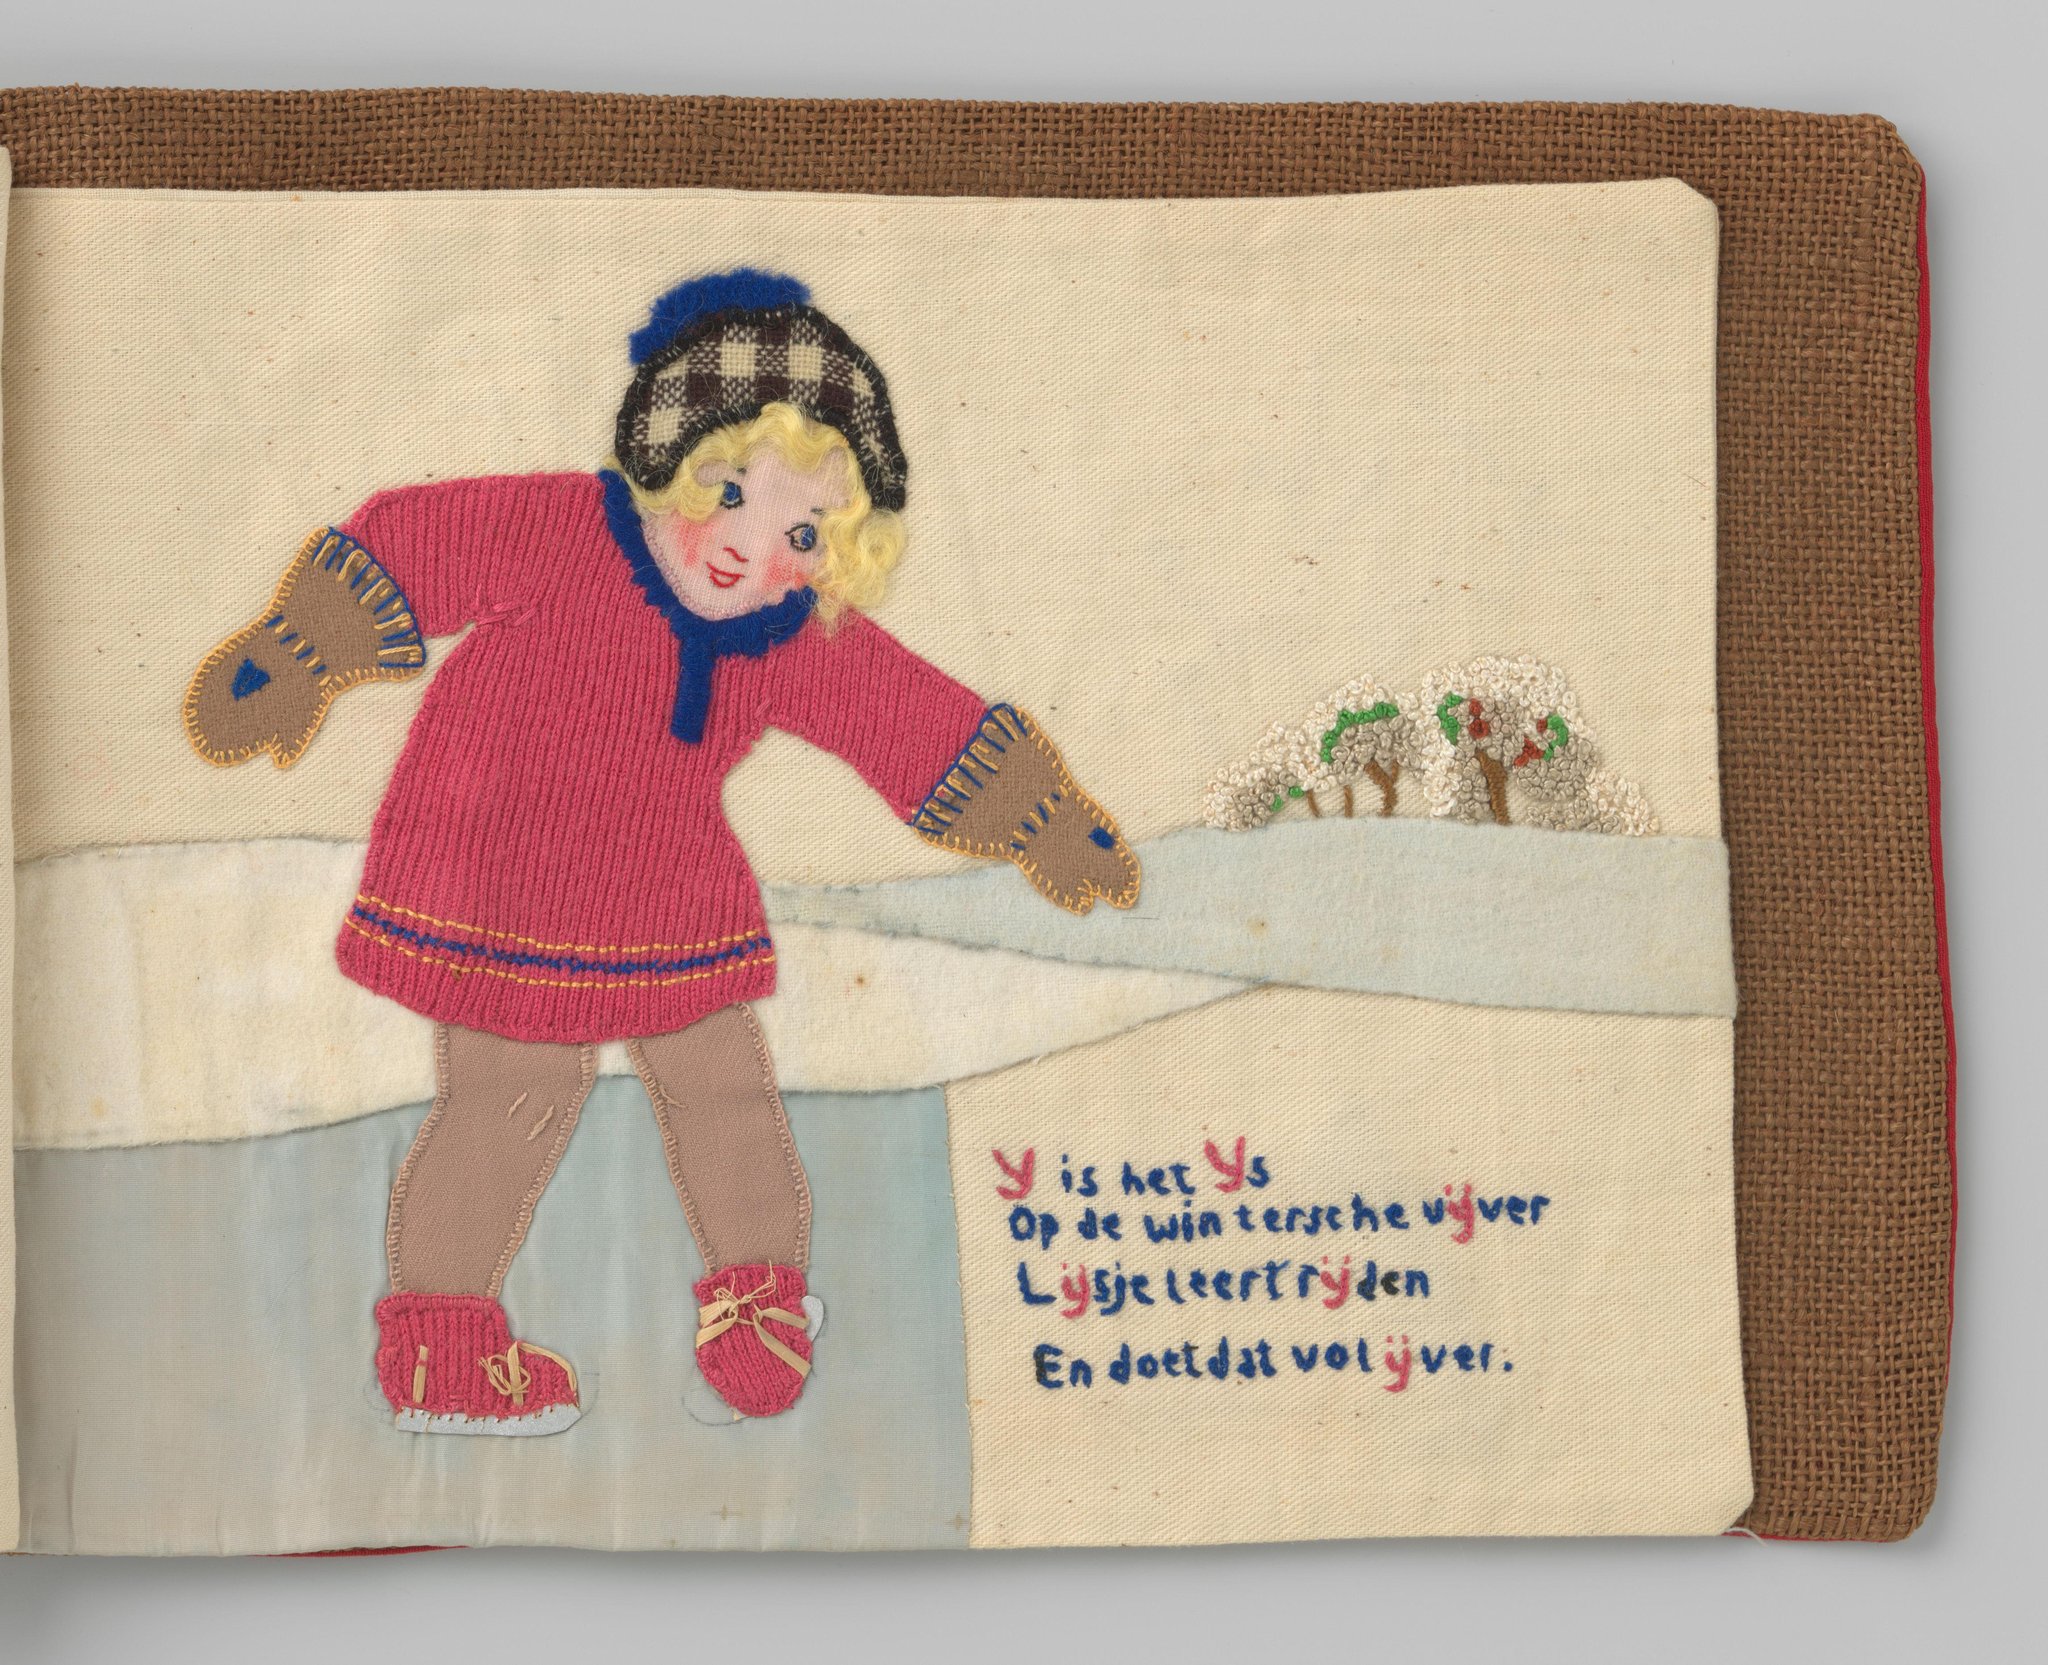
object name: blad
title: Y is het Ys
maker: miesje geertruida maria petronella aalbersberg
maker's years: 1915-1997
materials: cotton, textile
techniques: appliqué, embroidered, stitch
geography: brastagi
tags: reading, book in which illustrations are essential, letters, alphabet, script, internment camp, nursery school (+ teaching aids), (other forms of) needlework, e.g.: crocheting, knitting, embroidering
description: In het geheim gemaakt kinderboek in textiel vrij naar A is een Aapje van Rie Cramer. Het werd gezamenlijk gemaakt door de vrouwelijke gevangenen van het Japanse interneringskamp Brastagi, een oude plantage in Noord-Sumatra 60 kilometer ten zuiden van Medan aan de weg naar het Toba-meer, tijdens de Tweede Wereldoorlog ter gelegenheid van de vijfde verjaardag van Pem Hagers, de dochter van Miesje Hagers-Aalbersberg die de ontwerptekeningen en sjablonen had gemaakt.